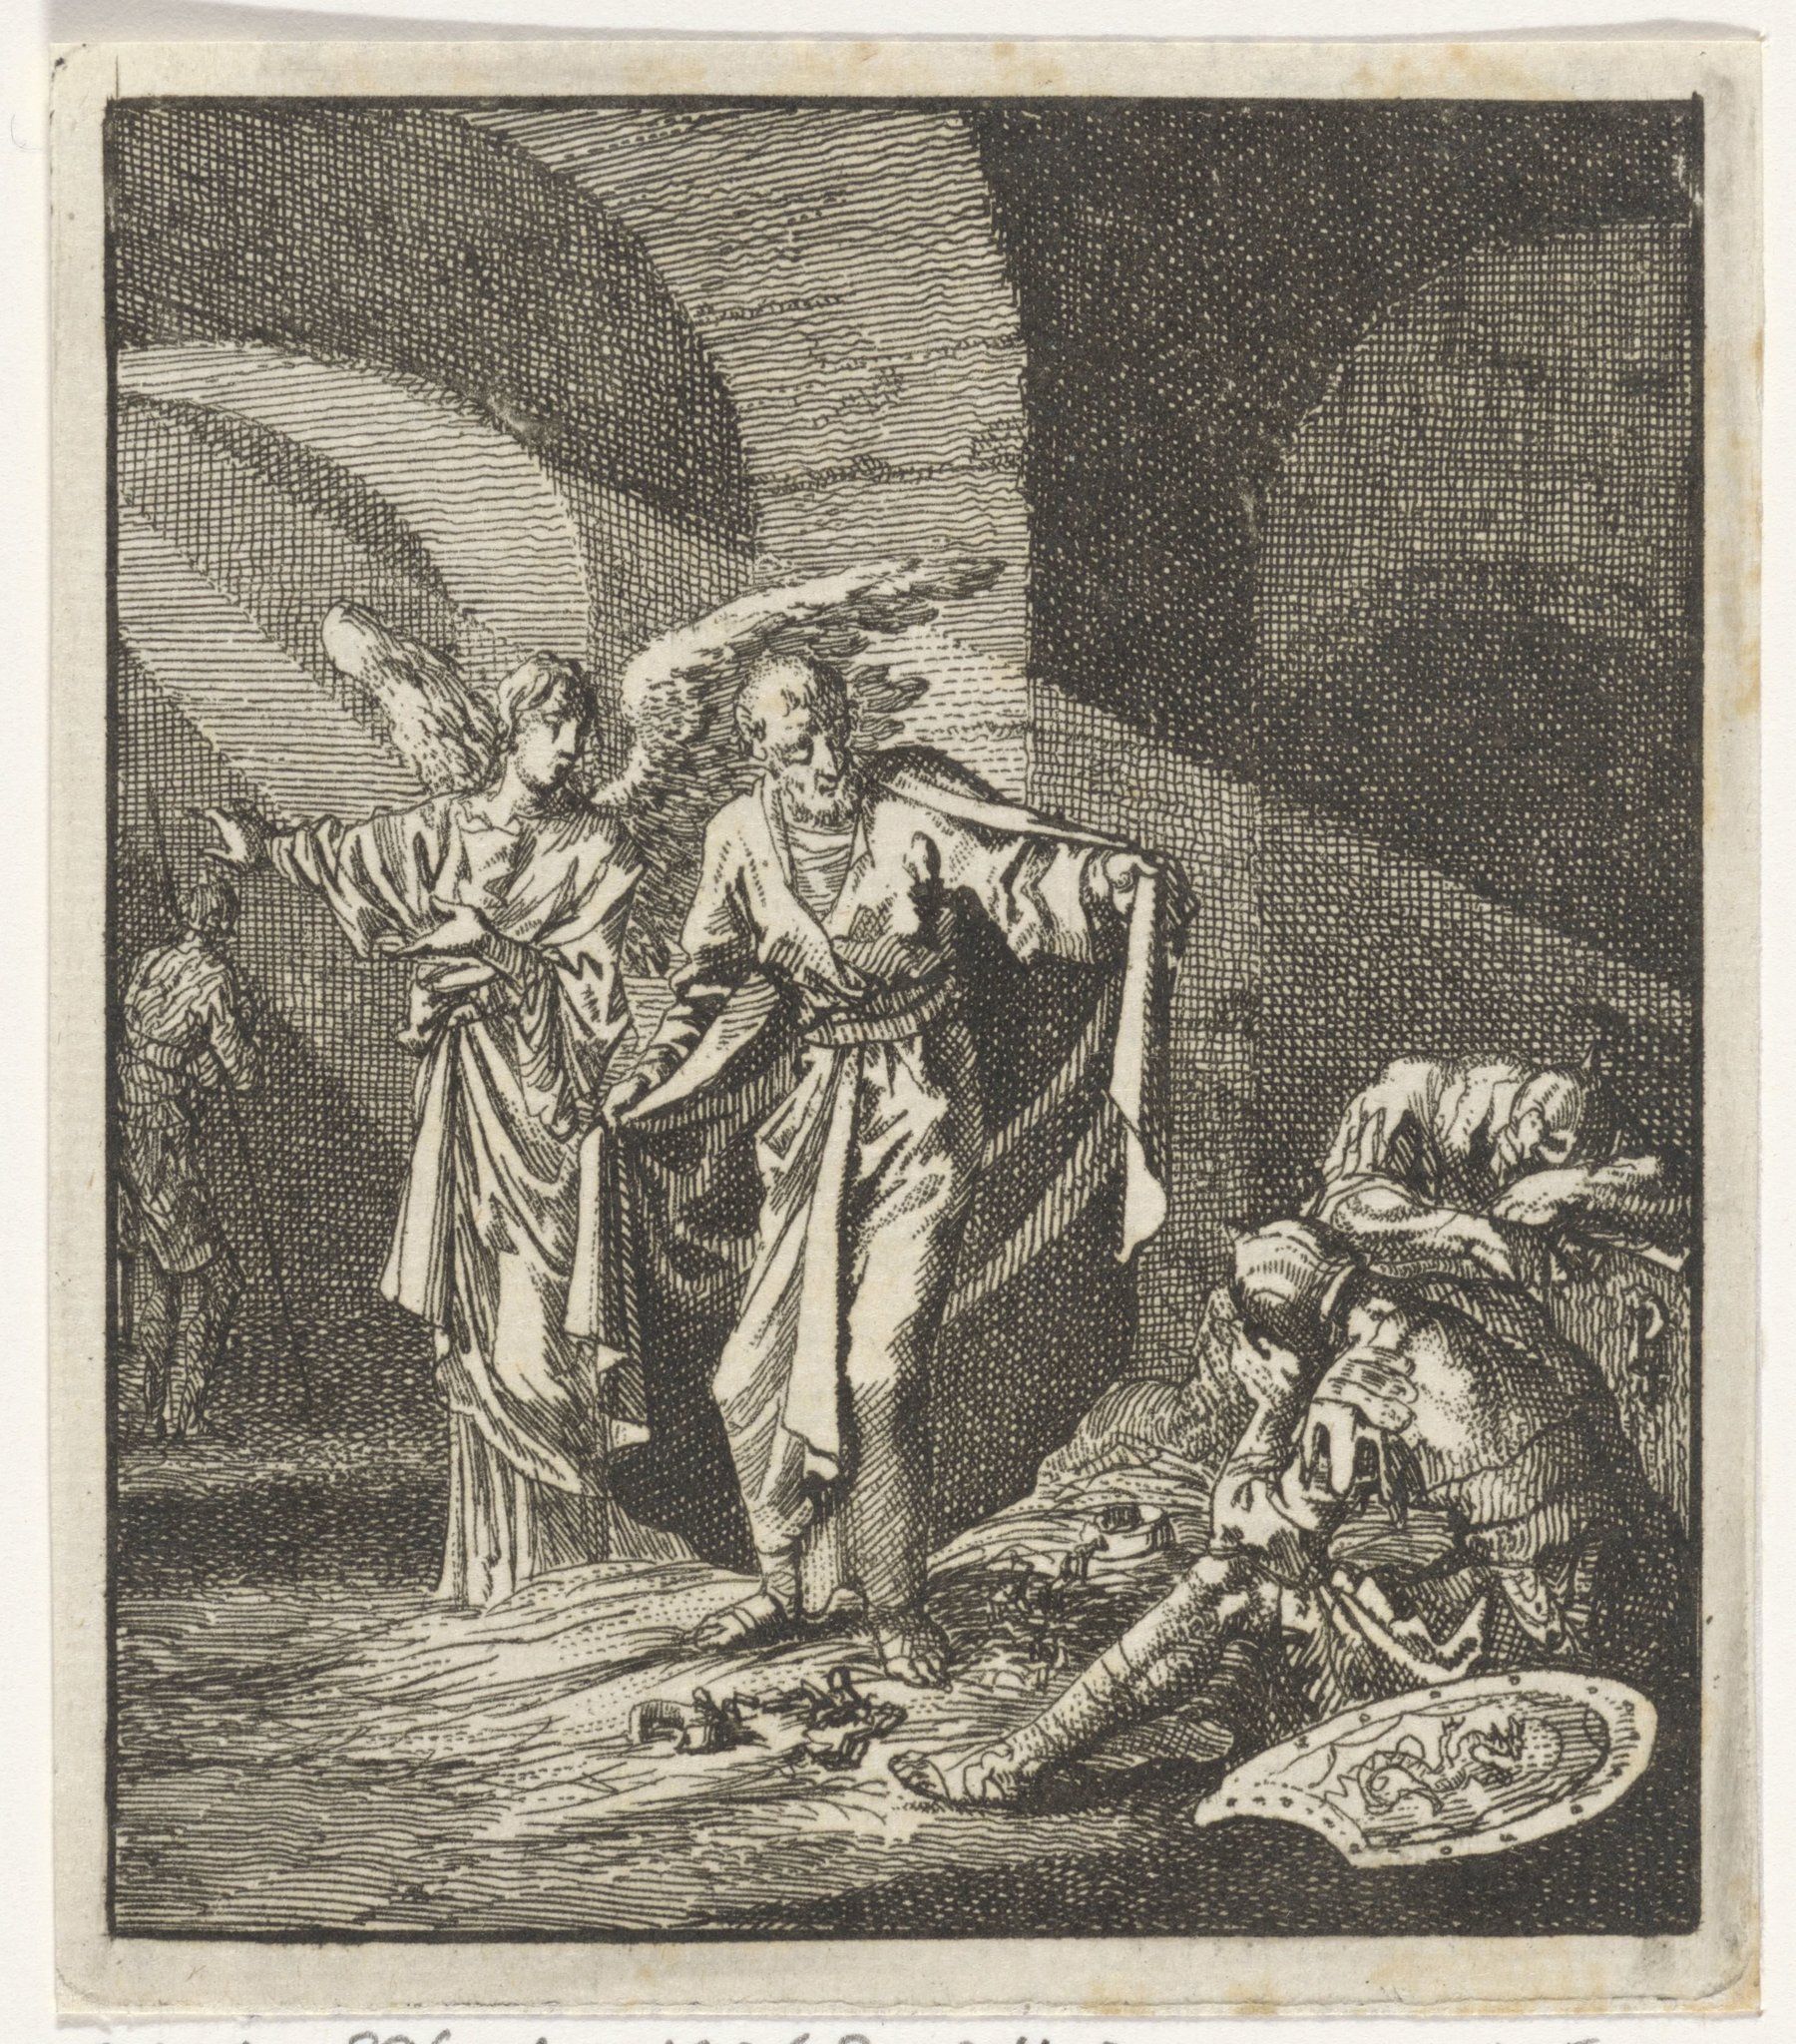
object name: book illustration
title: Petrus door de engel uit de gevangenis bevrijd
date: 1706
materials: paper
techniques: etching, letterpress printing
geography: amsterdam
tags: prison, jail, preaching (in general)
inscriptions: collector's mark: Lugt 2228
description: Illustratie voor: Schabaalje, Jean Philipsz. De vermeerderde lust-hof des gemoeds. Amsterdam: Jan Rieuwertsz. (II) en Barent Visscher, 1706, p. 447.